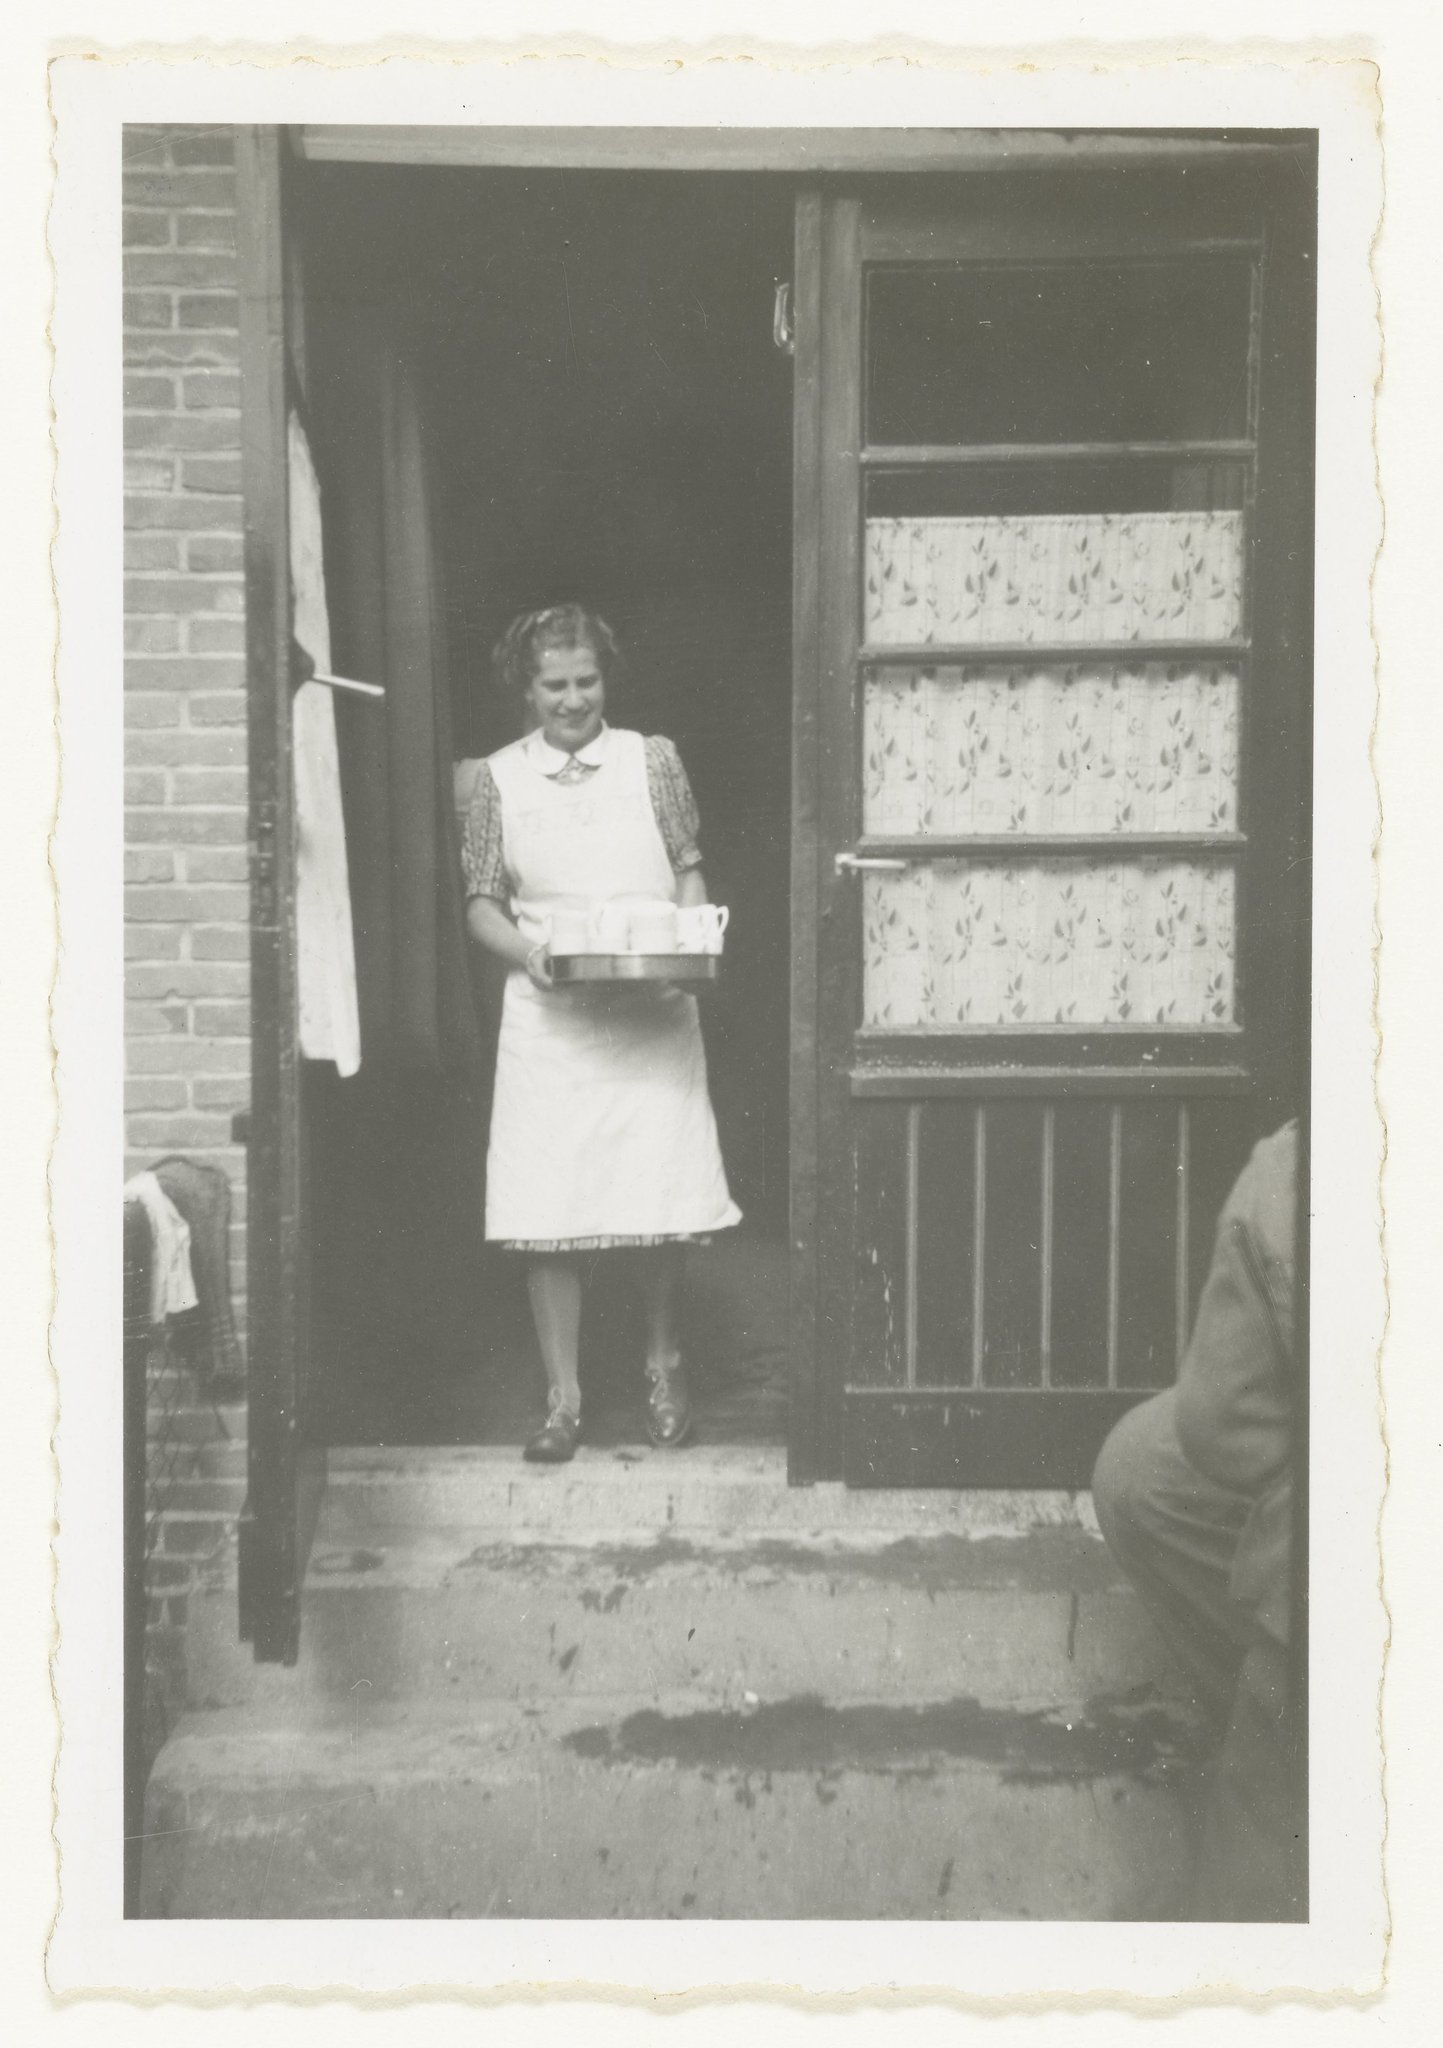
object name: photograph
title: Vrouw met blad met kopjes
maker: Anonymous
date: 1909-1940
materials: photographic support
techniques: gelatin silver print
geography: raamsdonksveer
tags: occupier and civilians, cup of coffee, occupation ~ war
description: Een Nederlandse vrouw komt een deur uit met een blad met kopjes in haar handen. Rechts is nog een klein stukje van een militair te zien. Raamsdonksveer. Achterop staat: Holland Sept. 1940. Maria Gamers hat uns Kaffee gebracht.